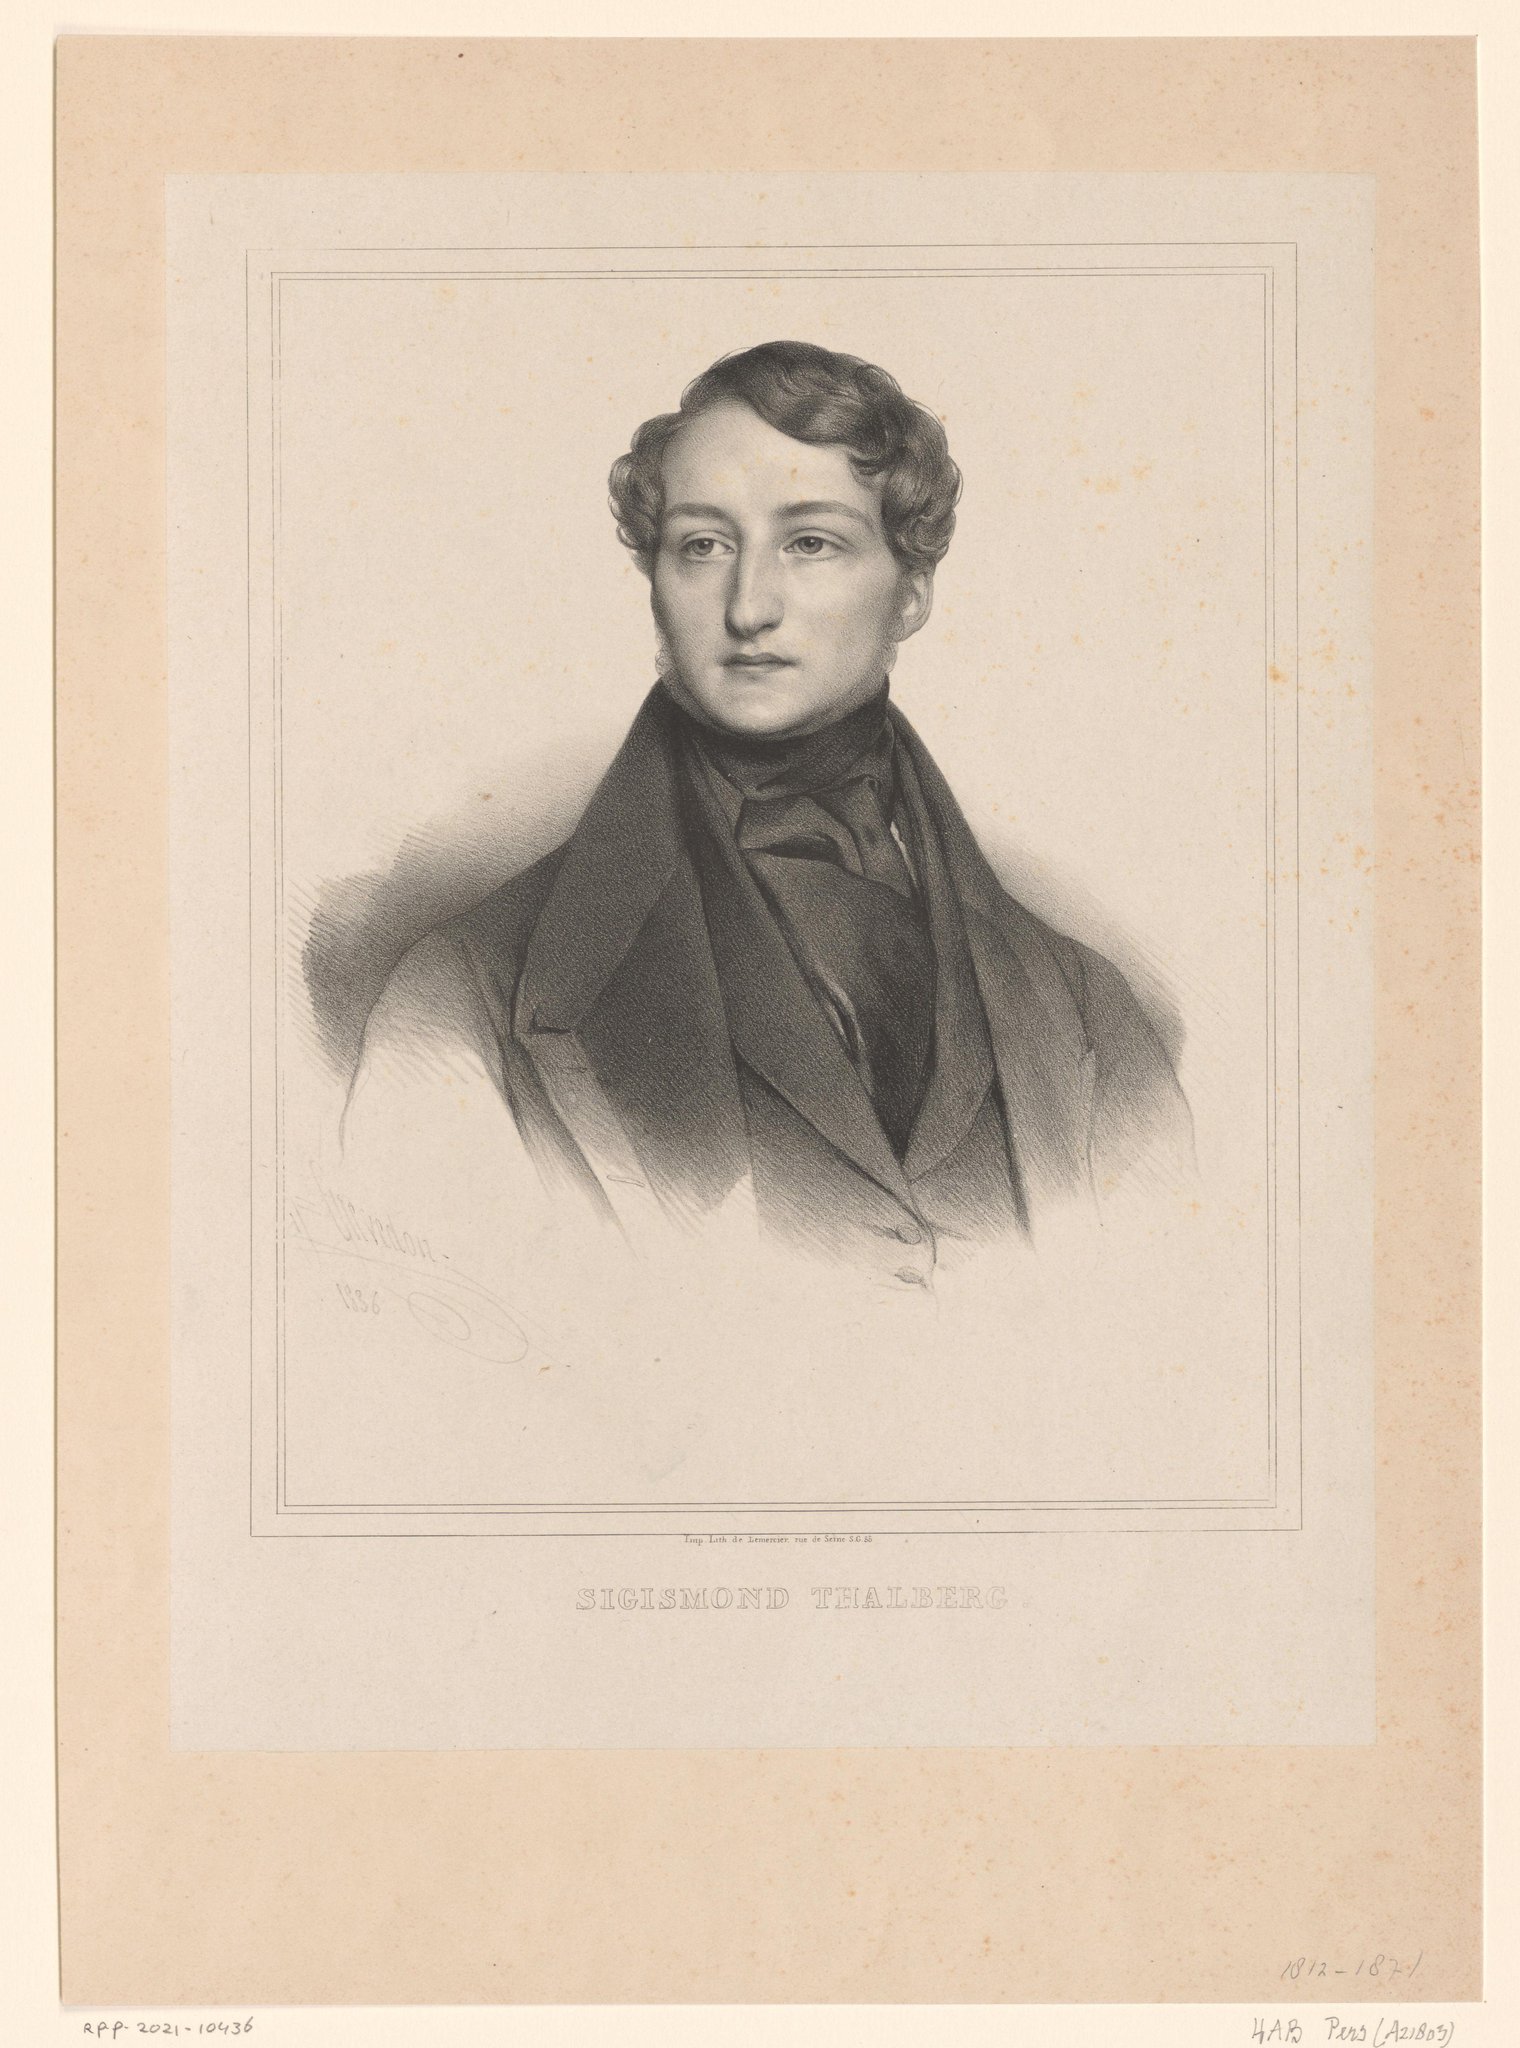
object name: print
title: Portret van Sigismund Thalberg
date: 1836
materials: paper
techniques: lithograph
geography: paris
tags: posillipo, collina di, adult man, historical persons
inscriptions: collector's mark: Lugt 2228